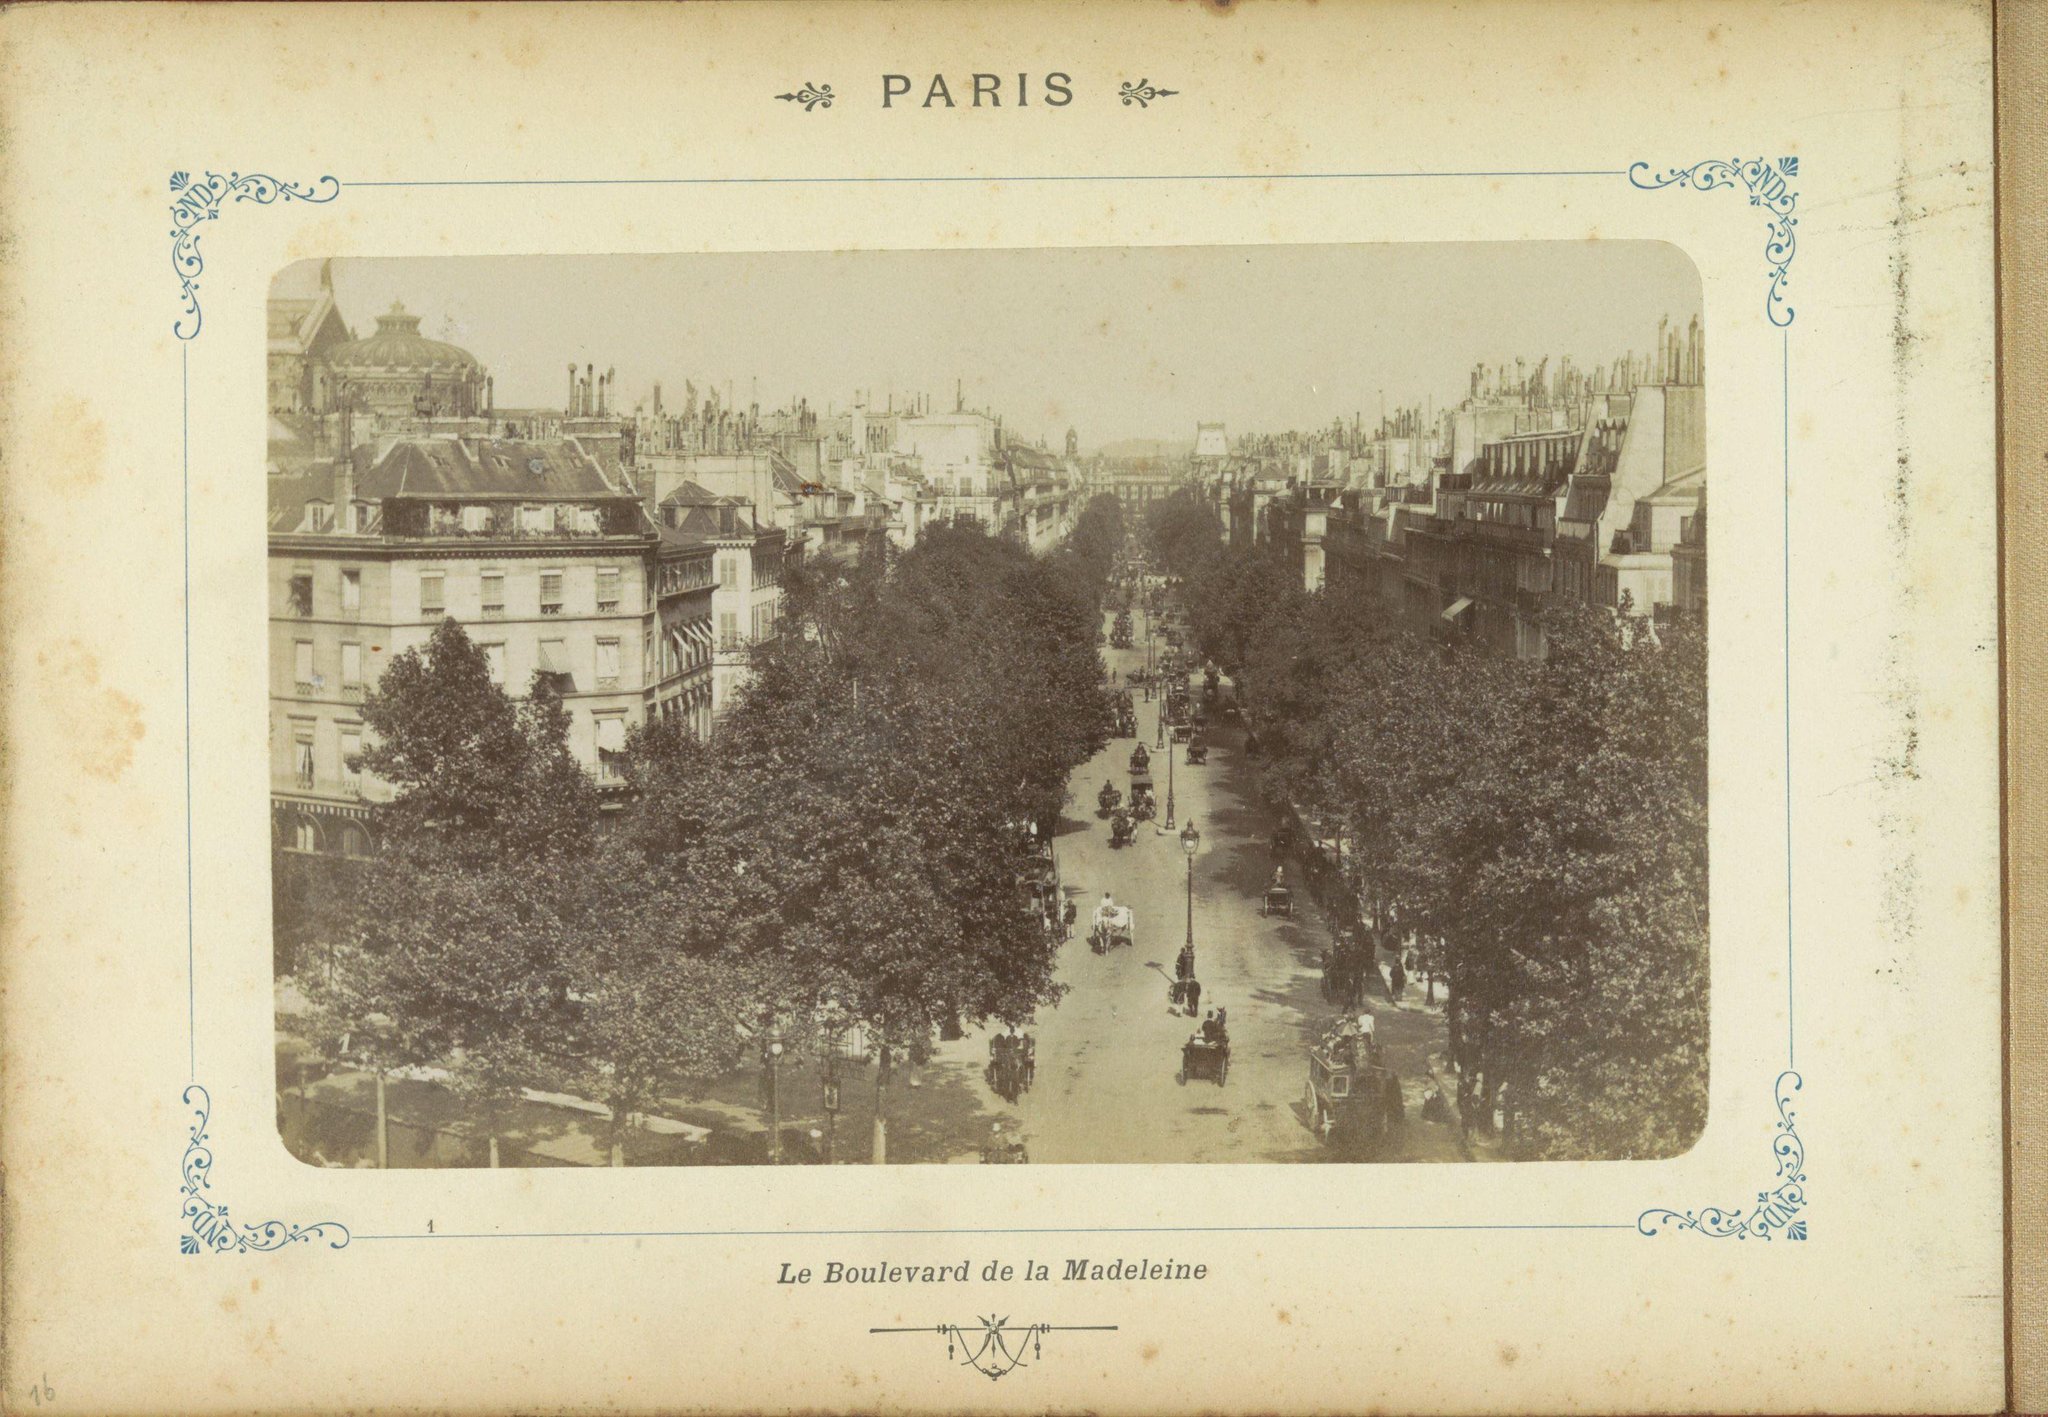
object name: photograph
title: Gezicht op de Boulevard de la Madeleine in Parijs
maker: Anonymous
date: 1900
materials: cardboard, paper, photographic support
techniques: albumen print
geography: paris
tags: animal traction, animal-drawn vehicle (carriage etc.), avenue, boulevard, promenade, esplanade (+ city(-scape) with figures, staffage), paris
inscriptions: number: ‘1’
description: Onderdeel van Fotoalbum met bezienswaardigheden in Parijs, Versailles en het Bois de Boulogne.